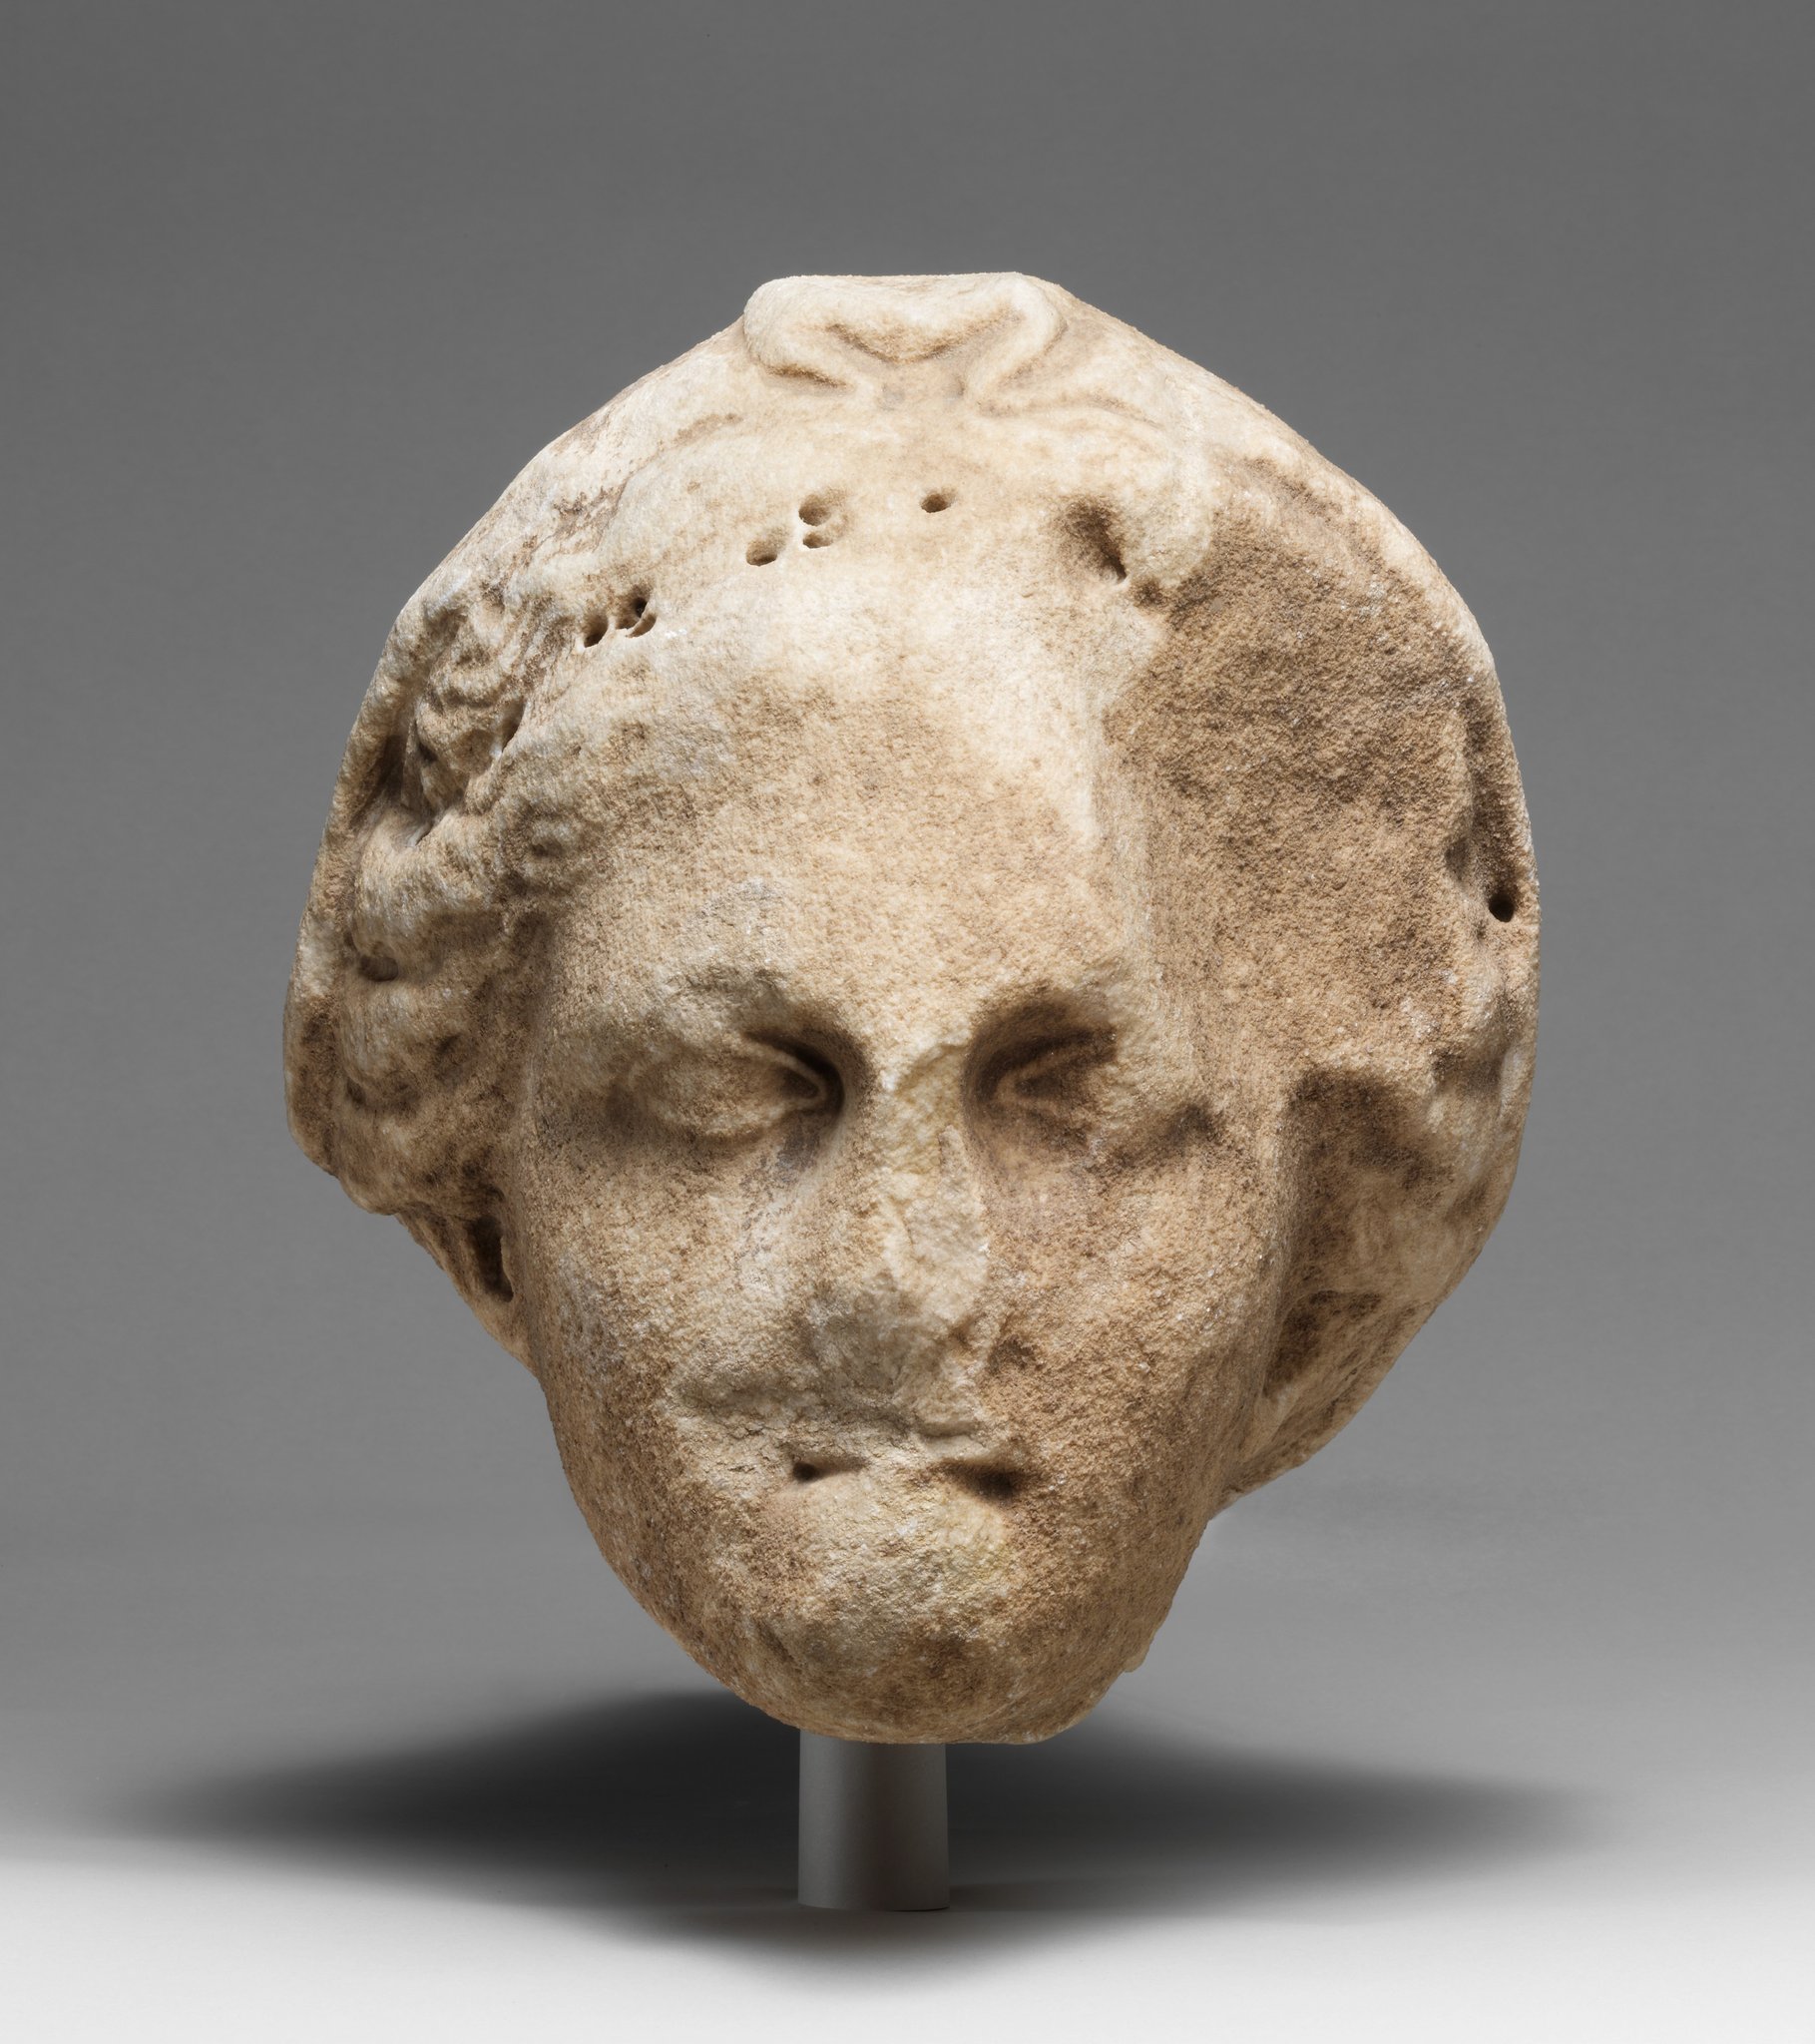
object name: head of a woman, veiled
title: Marble head of a veiled goddess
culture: greek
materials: marble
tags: goddess